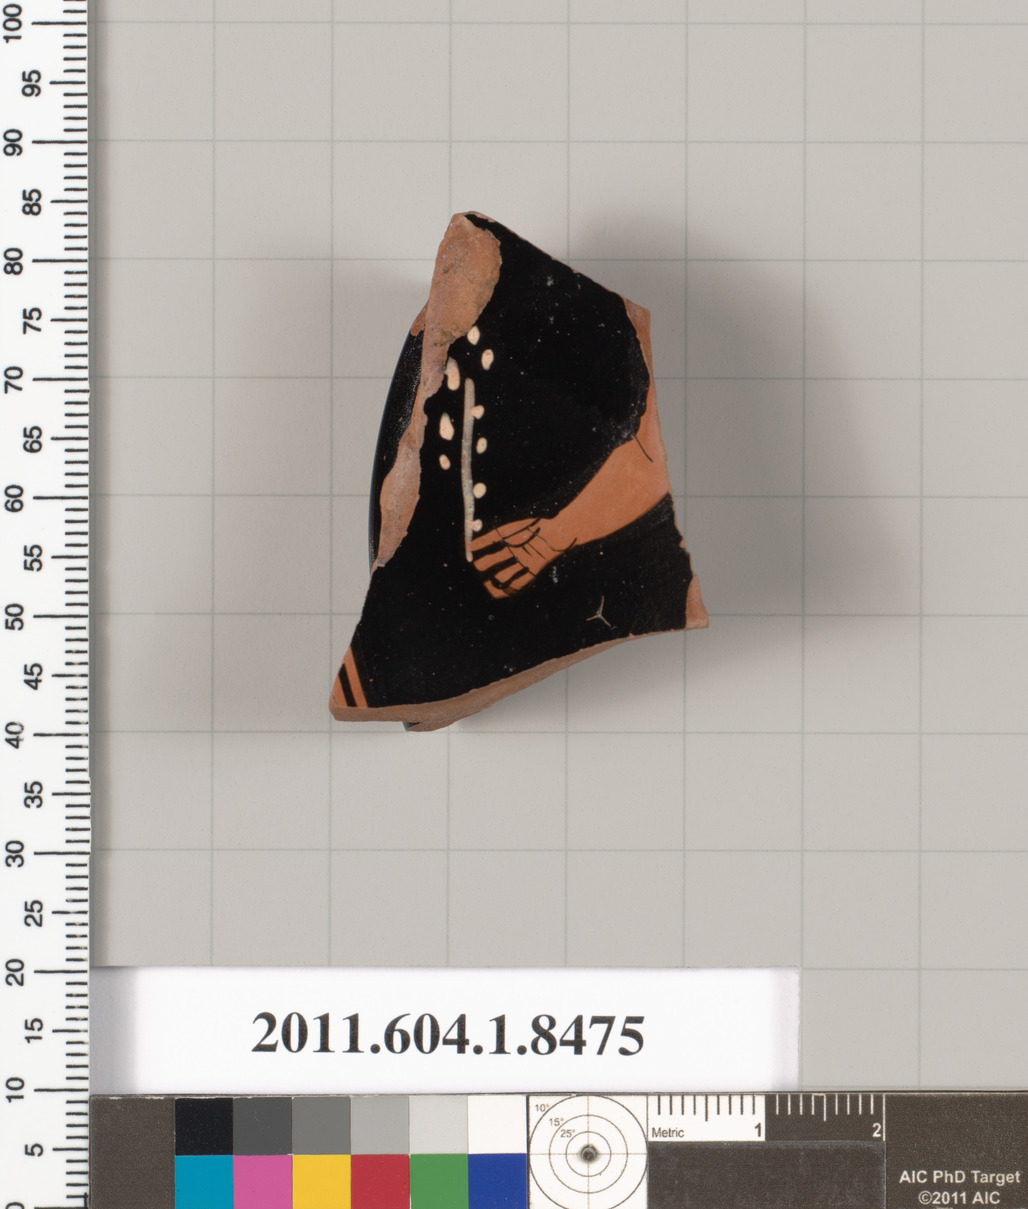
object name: kylix fragment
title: Terracotta fragment of a stemless kylix (drinking cup)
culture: greek, attic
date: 470-450 BCE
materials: terracotta